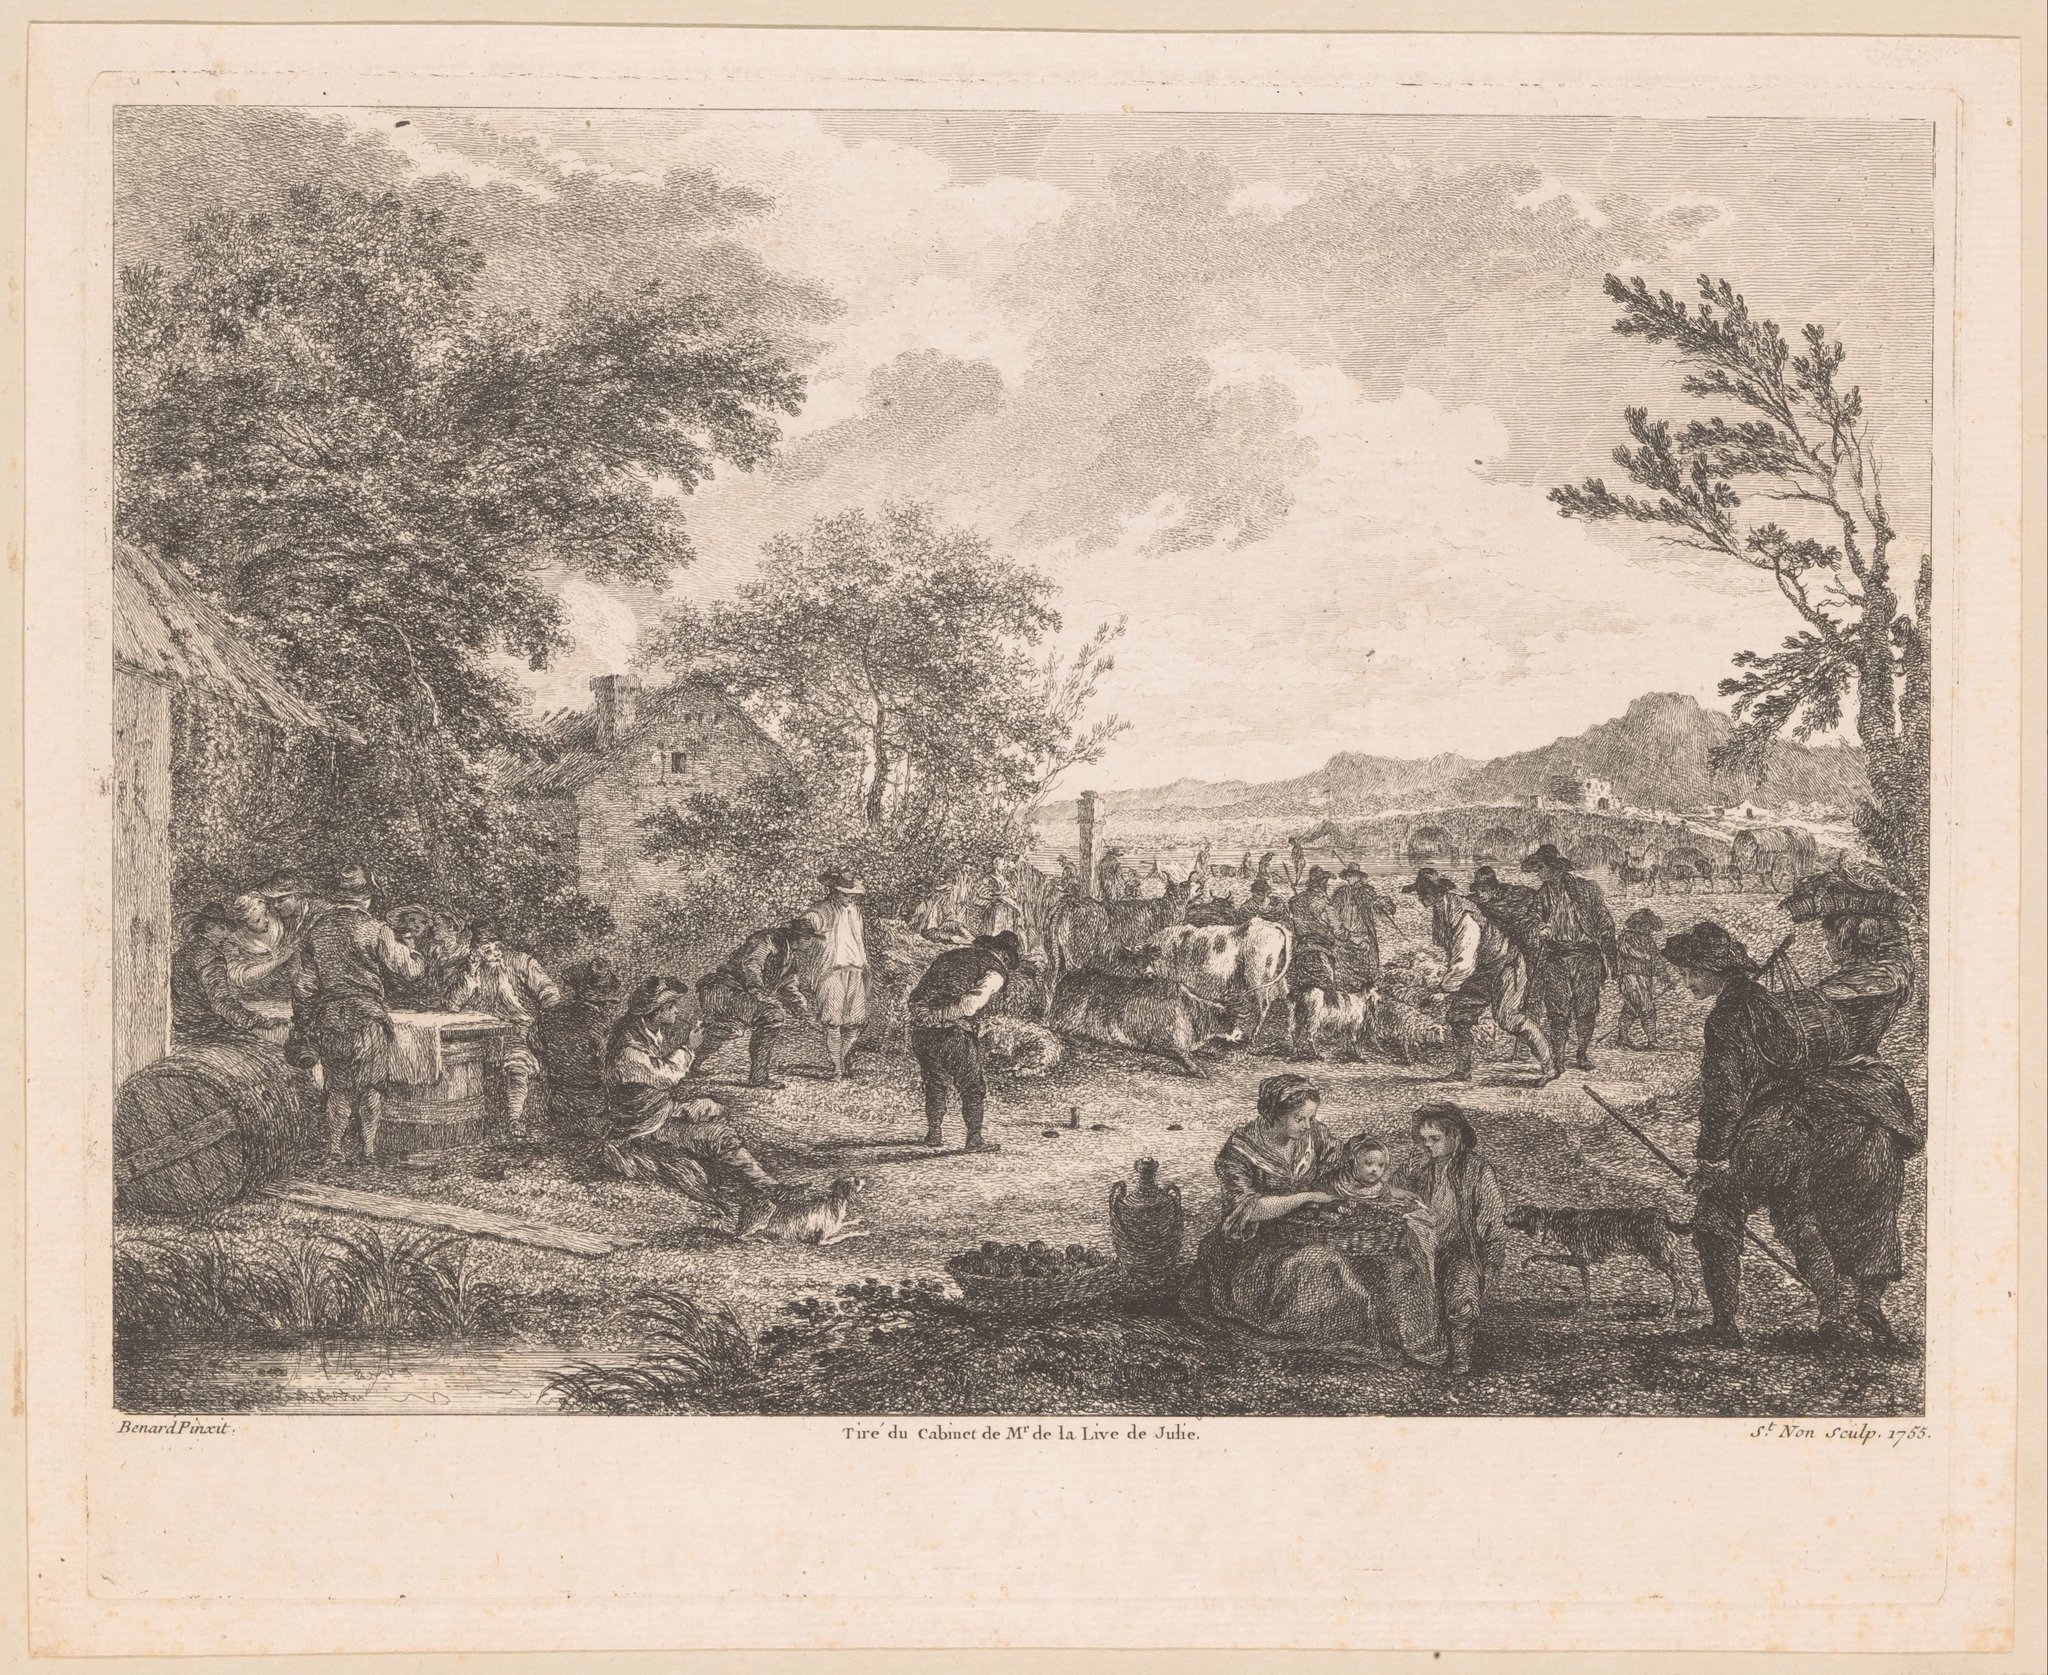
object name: print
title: Landschap met veemarkt en drinkende boeren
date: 1755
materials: paper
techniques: etching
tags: city-view, and landscape with man-made constructions, cattle, drinking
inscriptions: collector's mark: Lugt 240